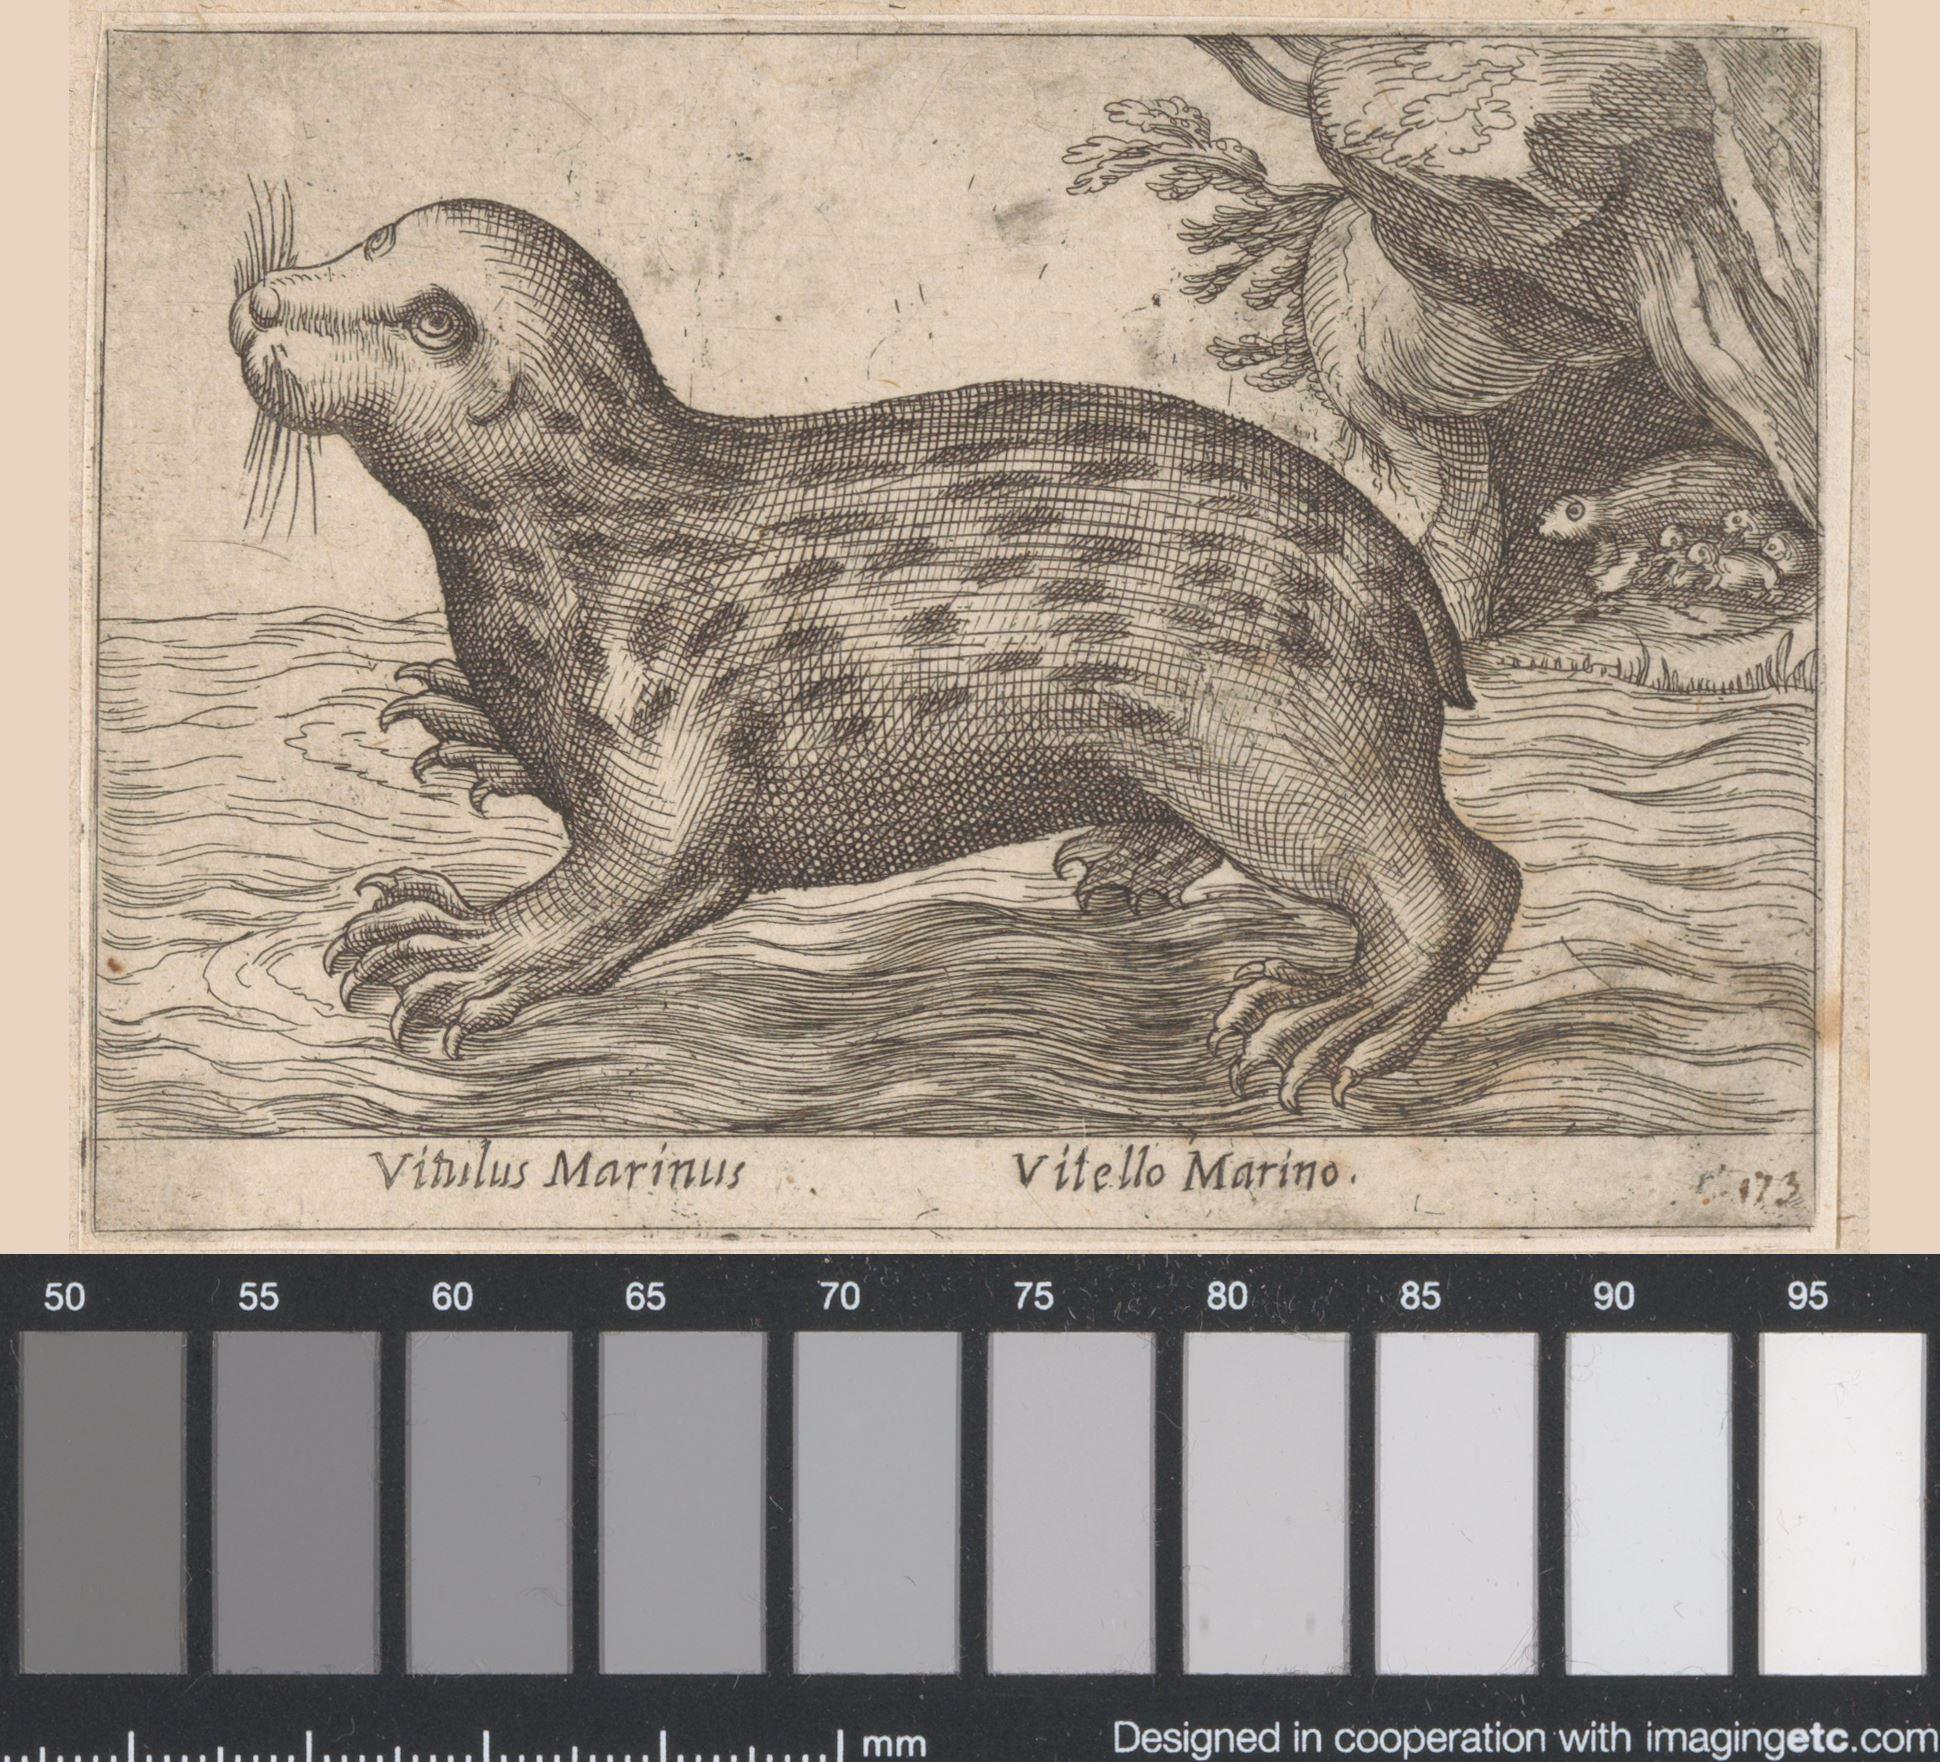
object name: print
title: Nova raccolta de li animali piu curiosi del mondo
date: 1565-1630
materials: paper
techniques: etching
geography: vatican city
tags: swimming mammals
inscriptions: collector's mark: Lugt 11, number: ‘173’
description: Deze prent maakt deel uit van een reeks prenten van dieren door Antonio Tempesta. Bekend is dat een tweede staat (met nummering) van deze serie is uitgegeven door Giovanni Giacomo de' Rossi in 1650. Onbekend is wie de eerste staat heeft uitgegeven en wanneer.